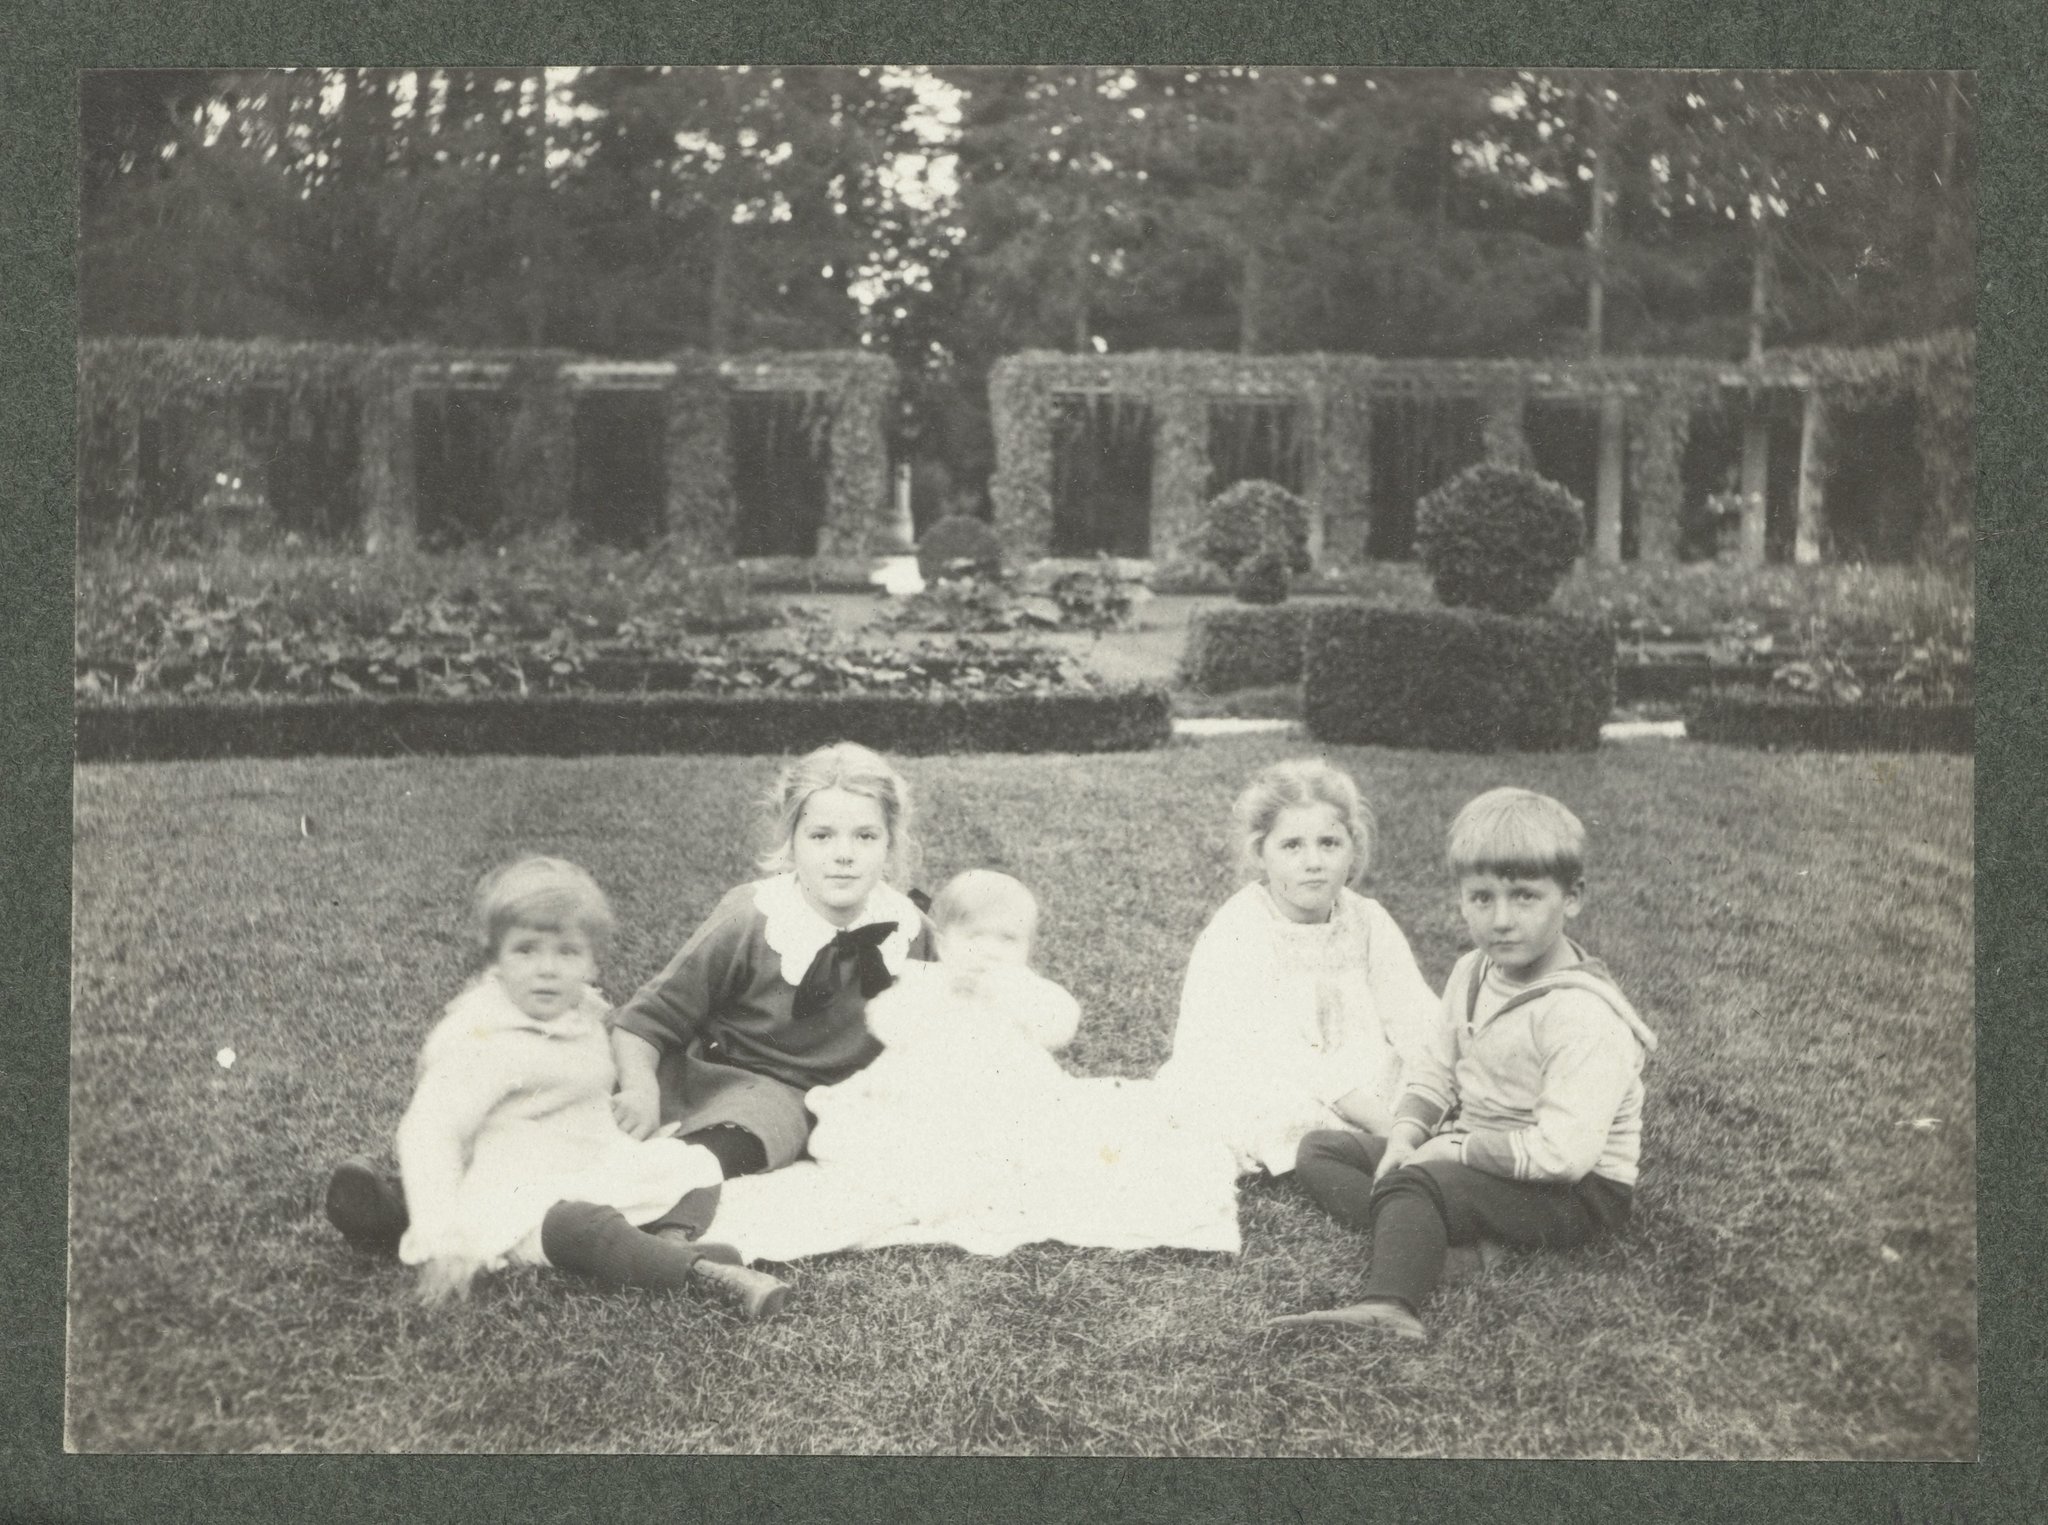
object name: photograph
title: Portret van kinderen zittend op een veld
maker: geldolph adriaan kessler (dolph)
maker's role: fotograaf, industrieel, voetballer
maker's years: 1884-1945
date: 1913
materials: paper, photographic support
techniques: photography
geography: netherlands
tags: huize de paauw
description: Vijf kinderen poseren zittend op een grasveld. Op de achtergrond zijn gesnoeide heggen en planten zichtbaar.